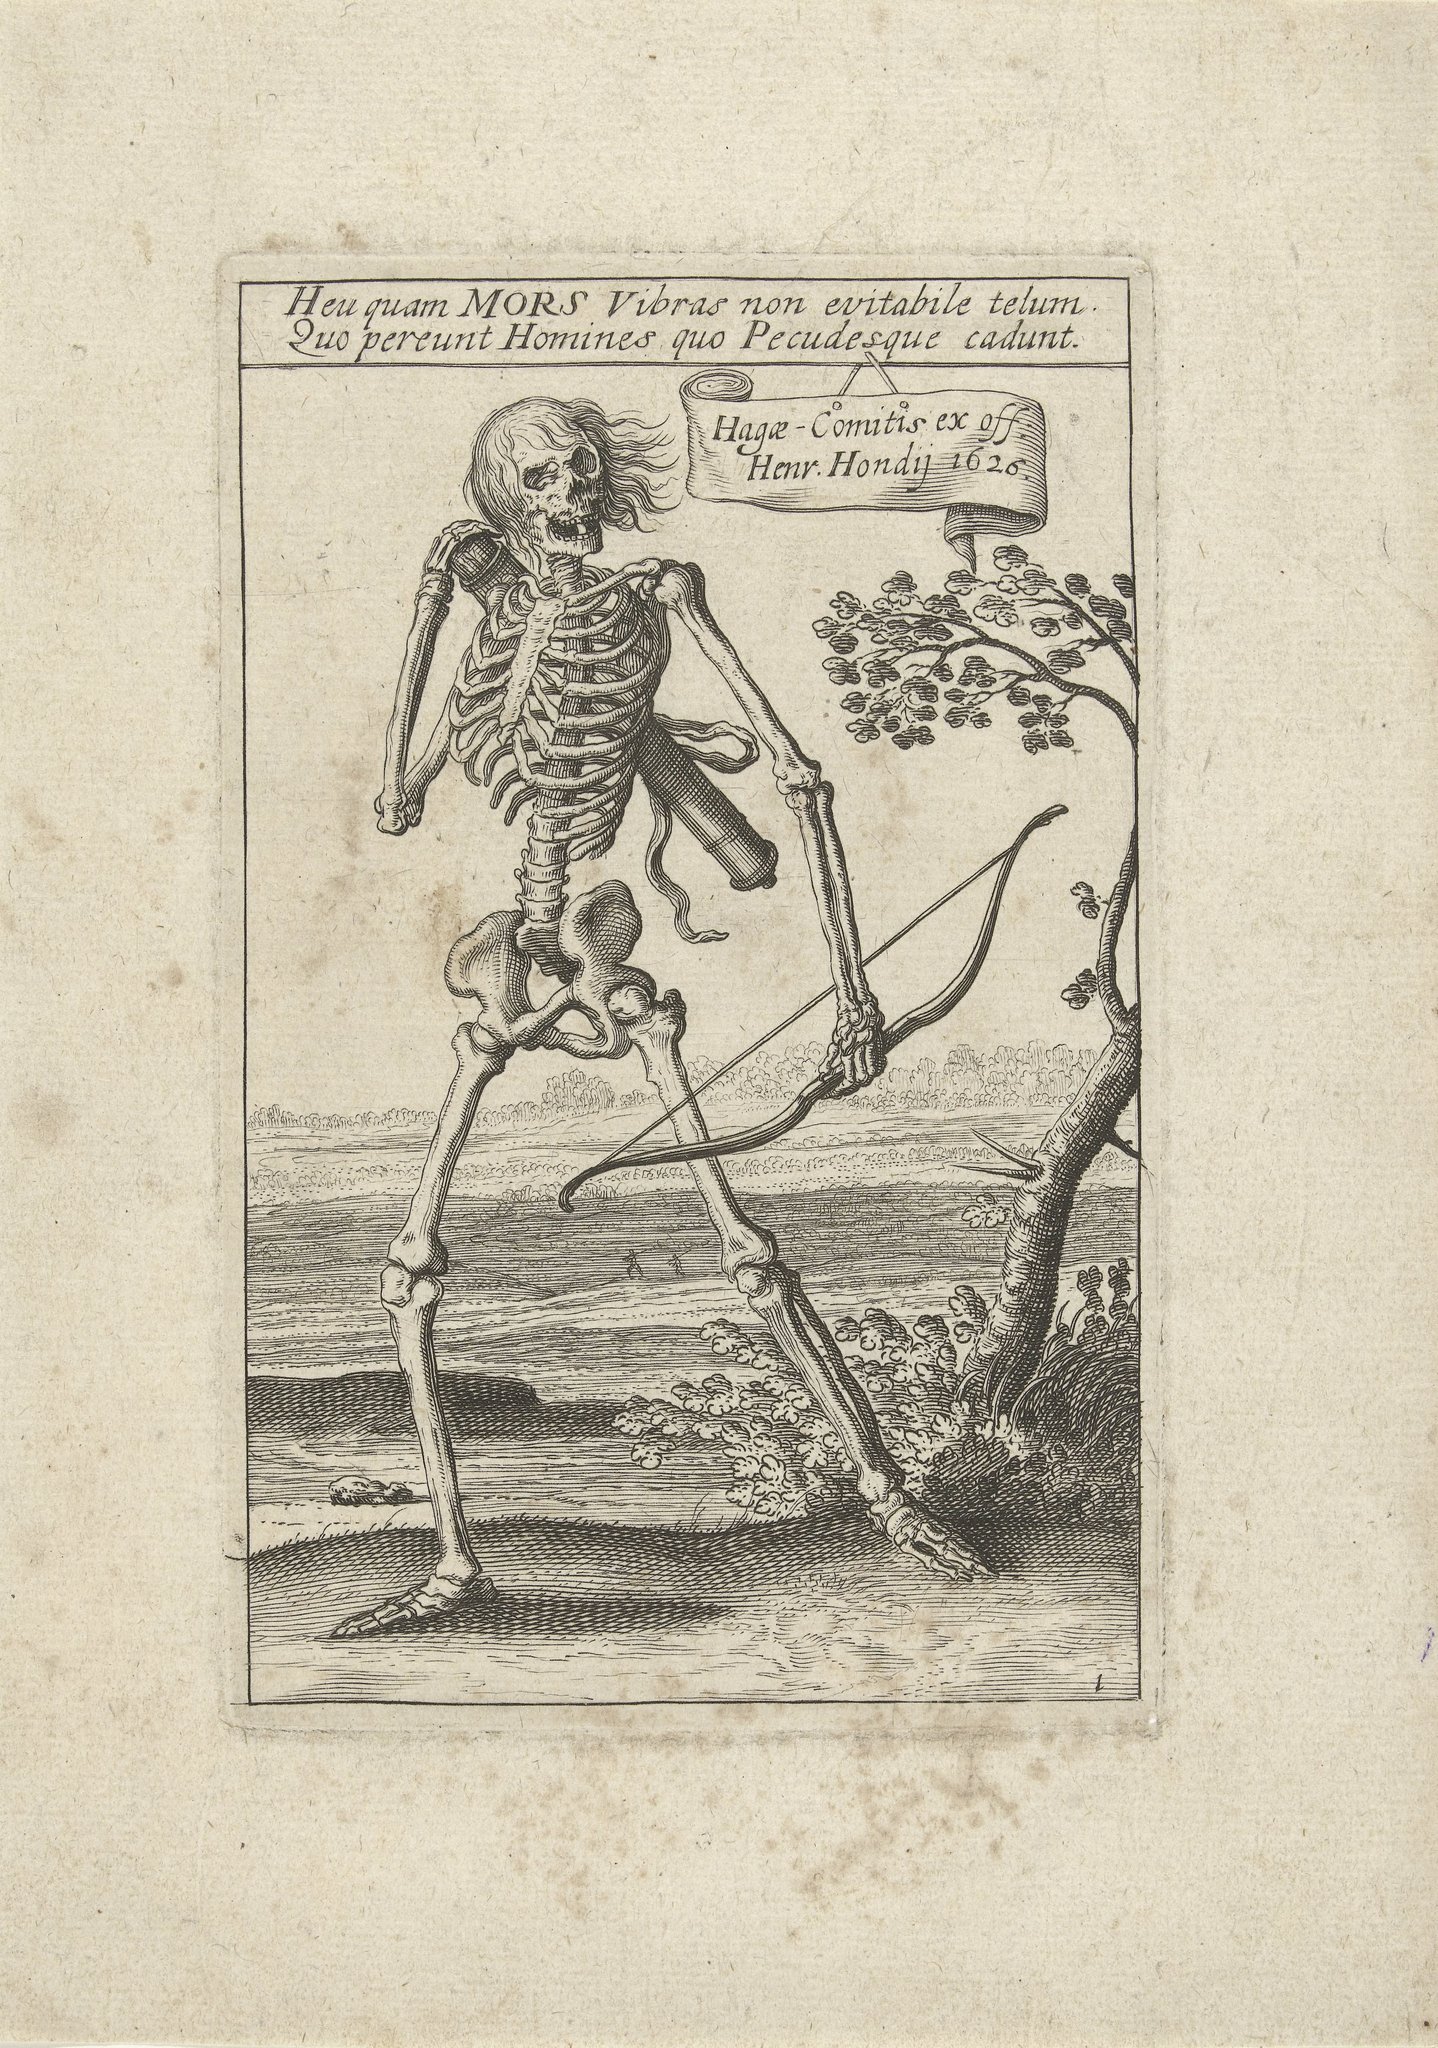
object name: titelprent, frontispice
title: Dierskeletten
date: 1625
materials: paper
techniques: engraving, etching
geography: the hague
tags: death as skeleton (+ death with bow and arrow)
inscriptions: collector's mark: Lugt 2228, inscription: ‘r.o.: No 1; boevanaan in kader: Heu quam MORS Vibras non evitabile telum Quo perunt Homines quo Pecudesque cadunt’, signature and date: ‘in banderol r.b.: Haegae-Comitis Ex off. Henr. Hondij1626’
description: De Dood in de gedaante van een skelet met een pijlenkoker op zijn rug en boog in de hand. Voor een landschap met rechts een boom. Prent uit een serie met voorstellingen van skeletten door de prentmakers Hendrick Hondius I (NewHollst.243-258), Andries Jacobsz. Stock (Hollst.4-10) en Simon Frisius.